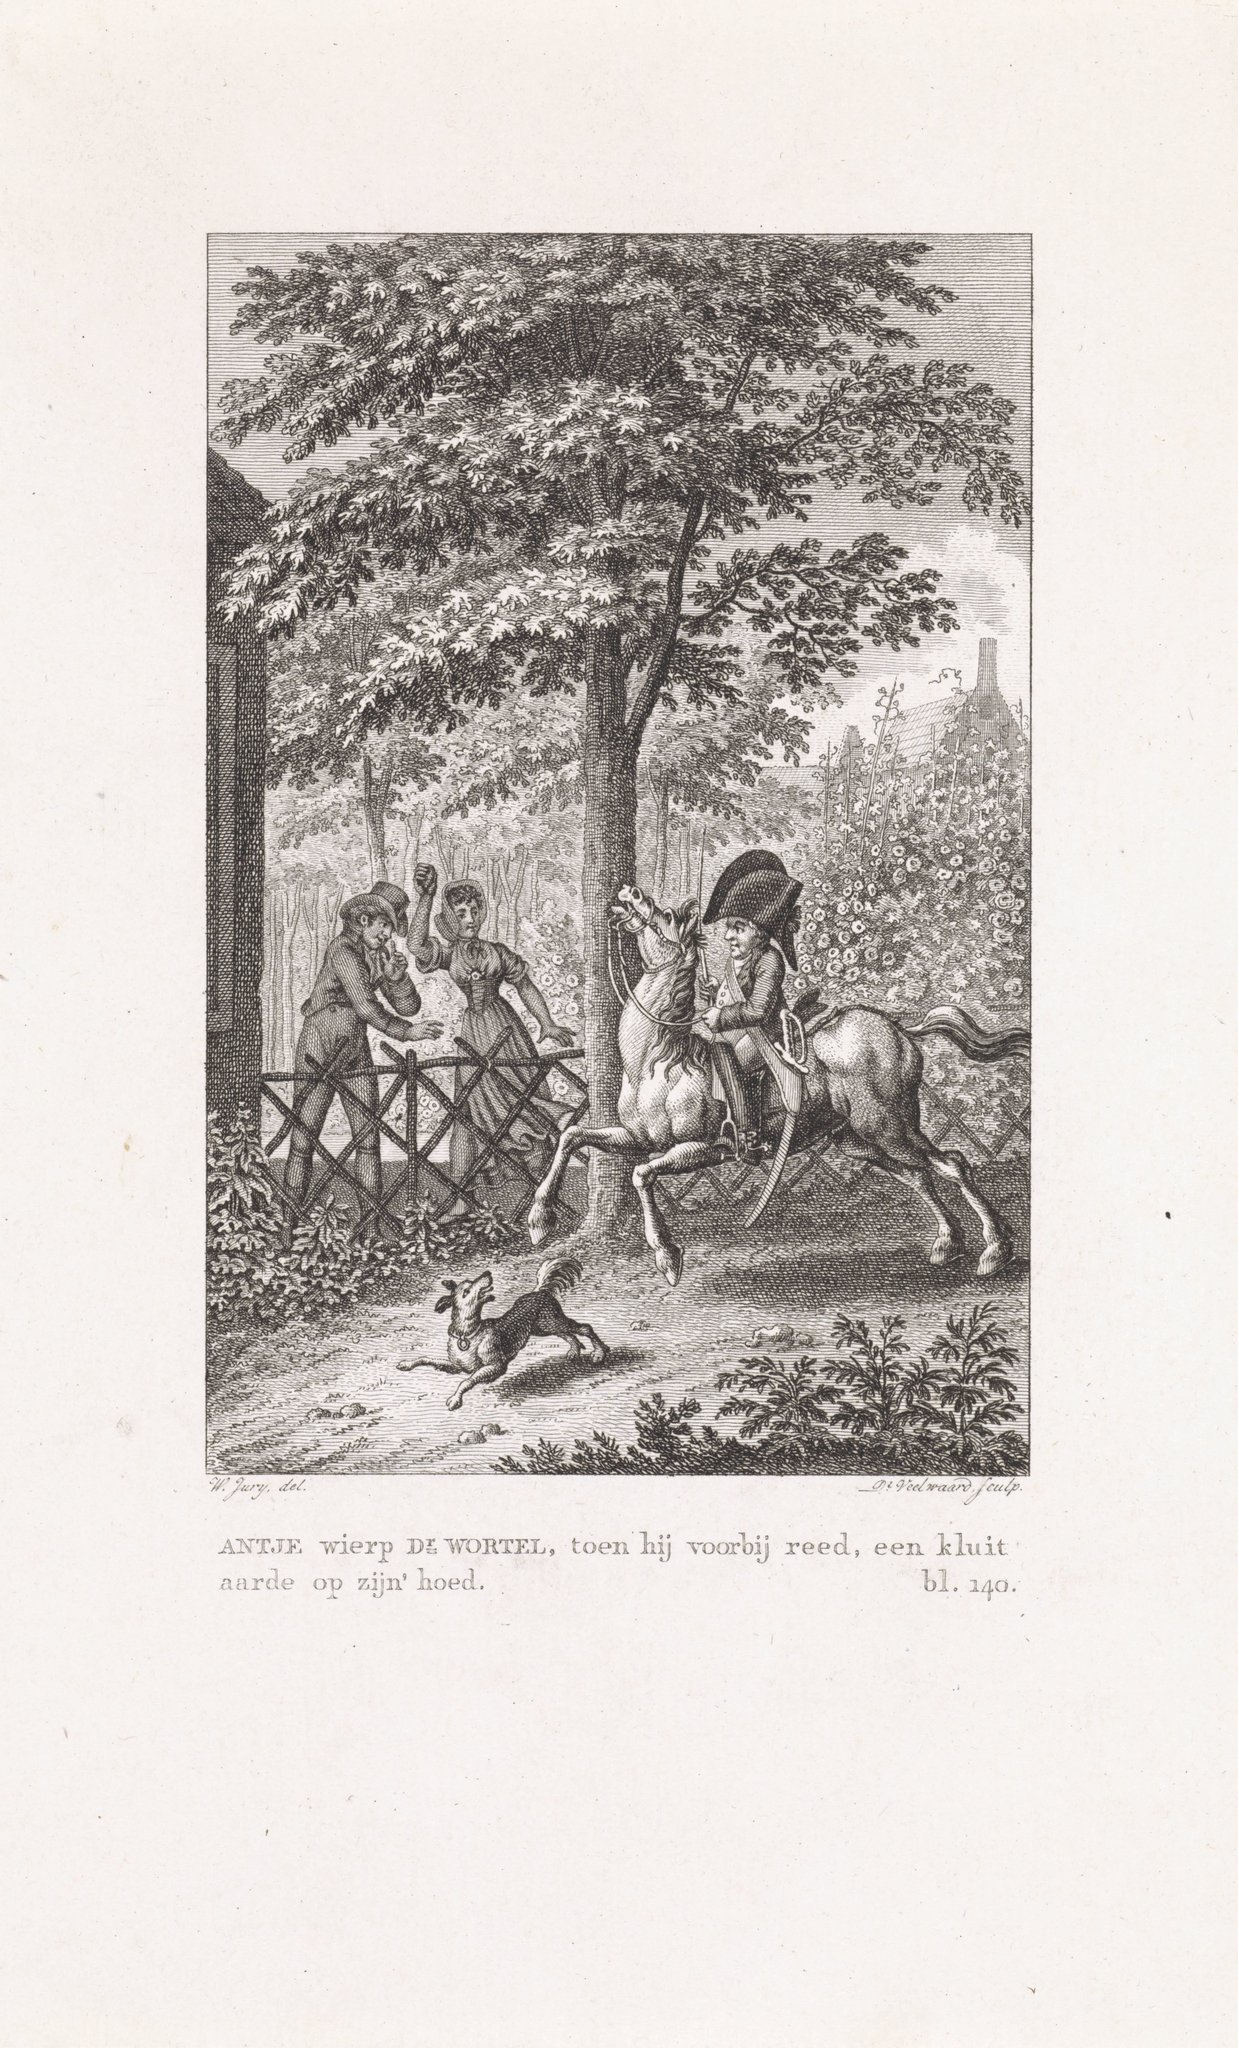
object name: book illustration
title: Antje wierp Dr. Wortel, toen hij voorbij reed, een kluit aarde op zijn' hoed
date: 1776-1851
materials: paper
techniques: engraving, etching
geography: amsterdam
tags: riding a horse, ass, or mule; rider, horseman, throwing something - aa - female human figure, dog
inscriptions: collector's mark: Lugt 2228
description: Een vrouw gooit van achter een hek iets naar een man met een steek op het hoofd, zittend op een paard. Voor de ruiter op het pad een hond. Rechtsonder: bl. 140.